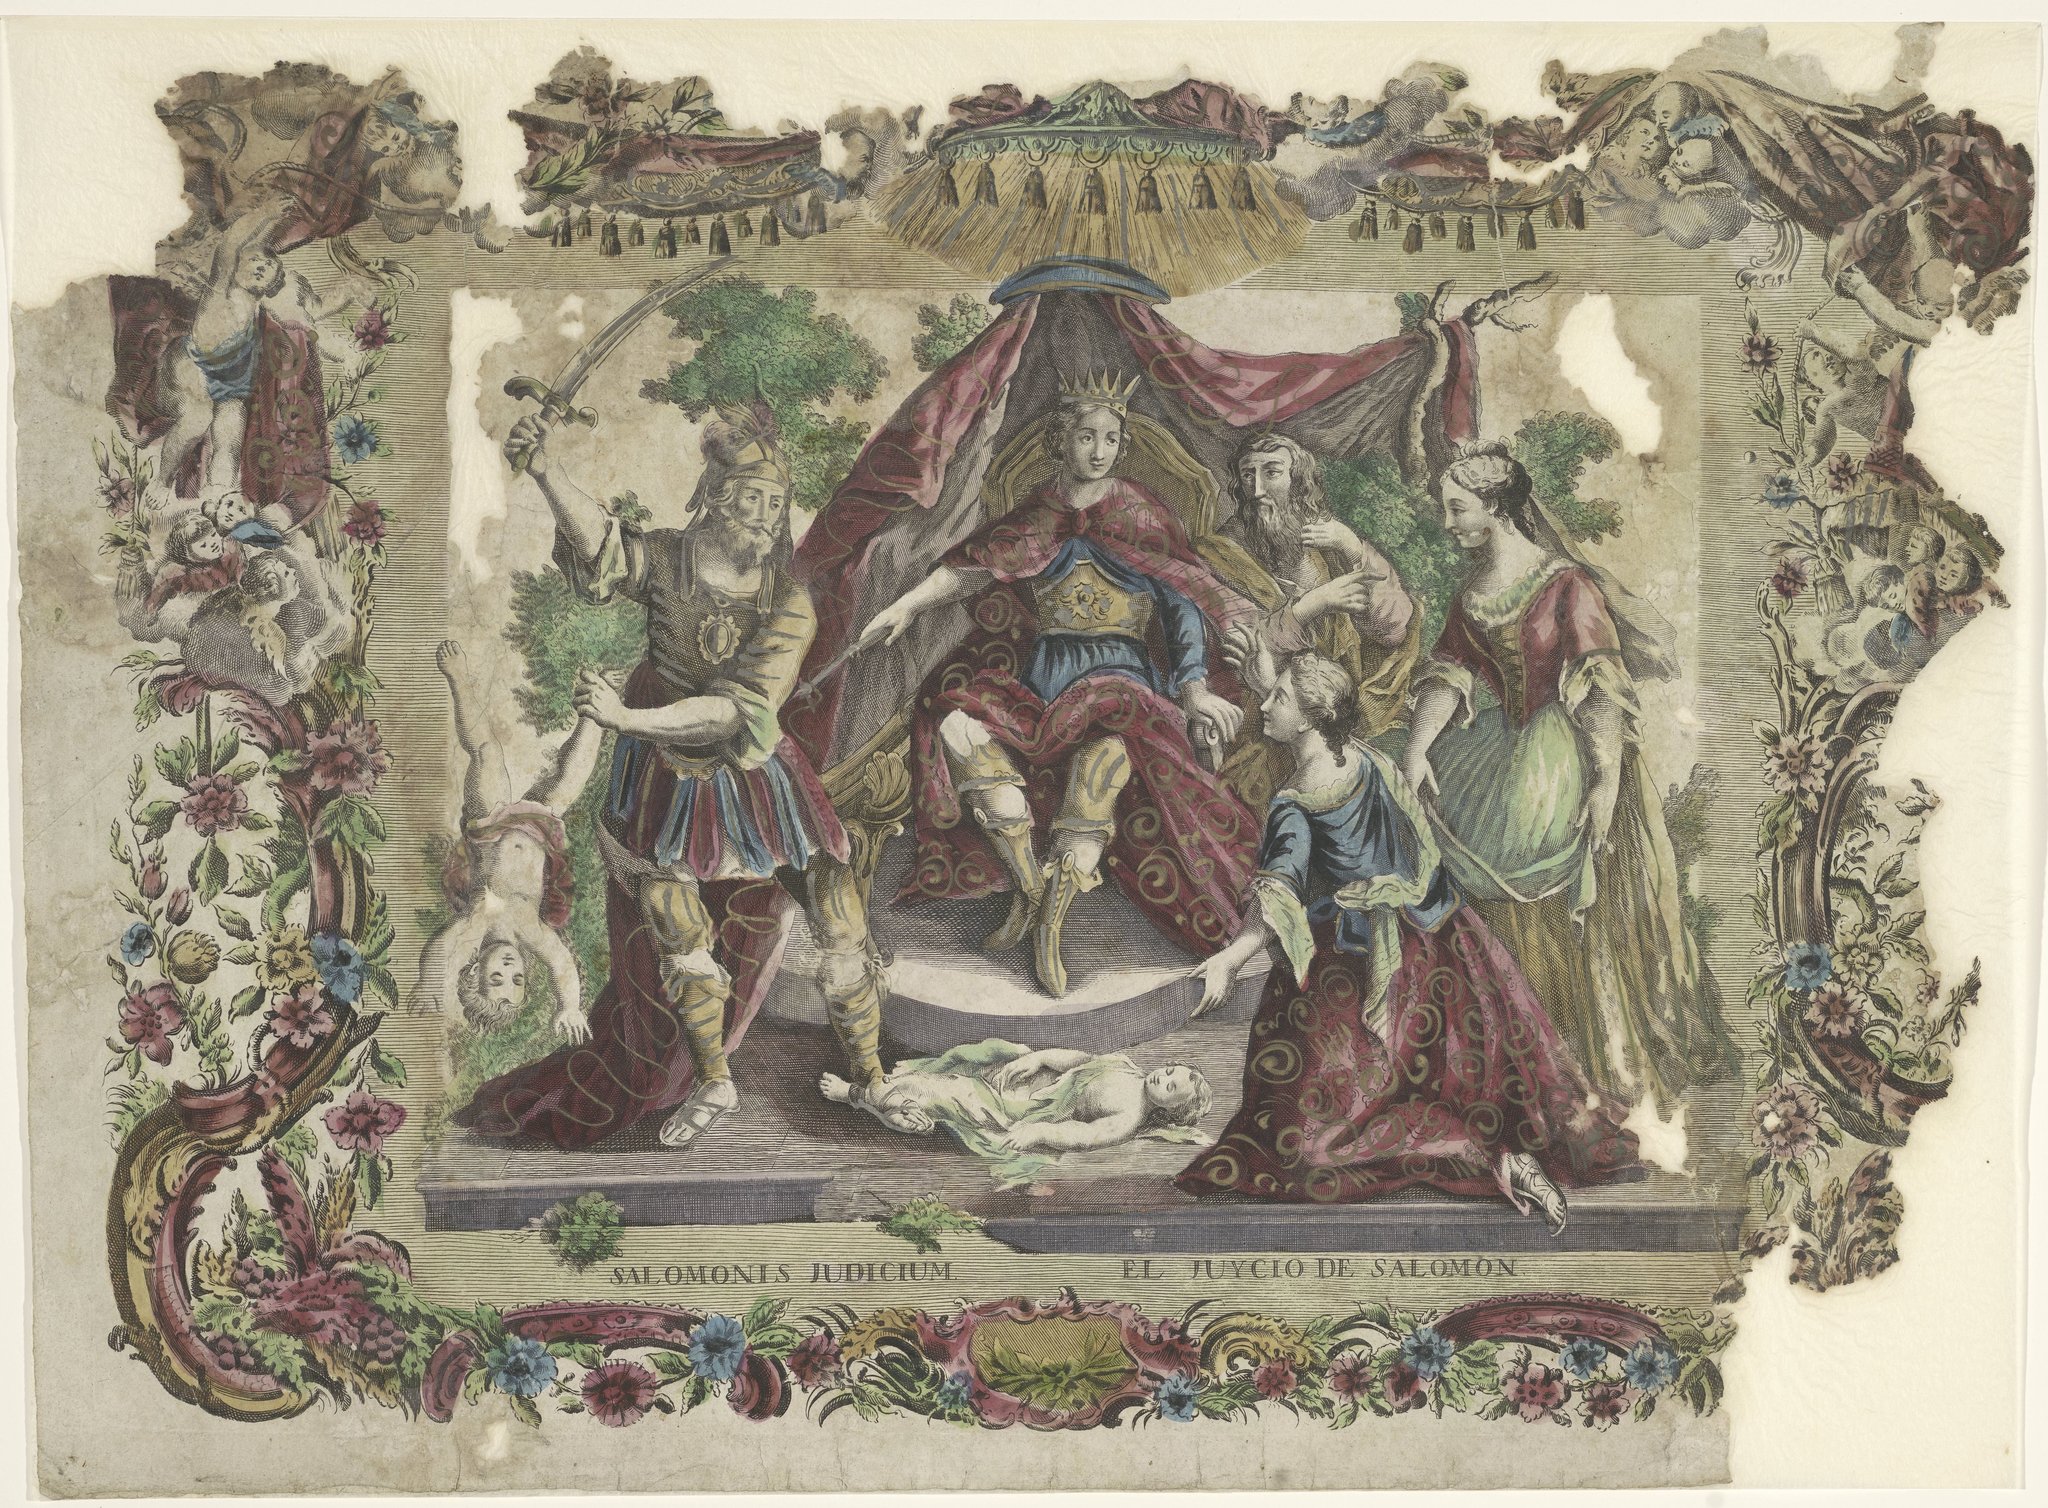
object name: print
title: Het oordeel van Salomo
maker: giovanni volpato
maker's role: ceramicist, print maker, printer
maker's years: 1735-1803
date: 1700-1799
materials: paper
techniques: colour, engraving, etching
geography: bassano del grappa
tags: cherubs, i.e. children's heads with wings, ornaments ~ art, solomon gives verdict; he commands a soldier to divide the living child in two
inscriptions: collector's mark: Lugt 2228, collector's mark: Lugt 2760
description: Salomo zit als jonge koning op zijn troon, van voren gezien. Voor de troon ligt een dood kind op de grond. Links een soldaat die op het punt staat het levende kind doormidden te snijden. Rechts de twee moeders. Schuin achter de troon een man met baard die wijst naar een van hen. Titel in twee talen onder voorstelling. De scène is gevat in een ornamentrand met bloemen en cherubijnen.